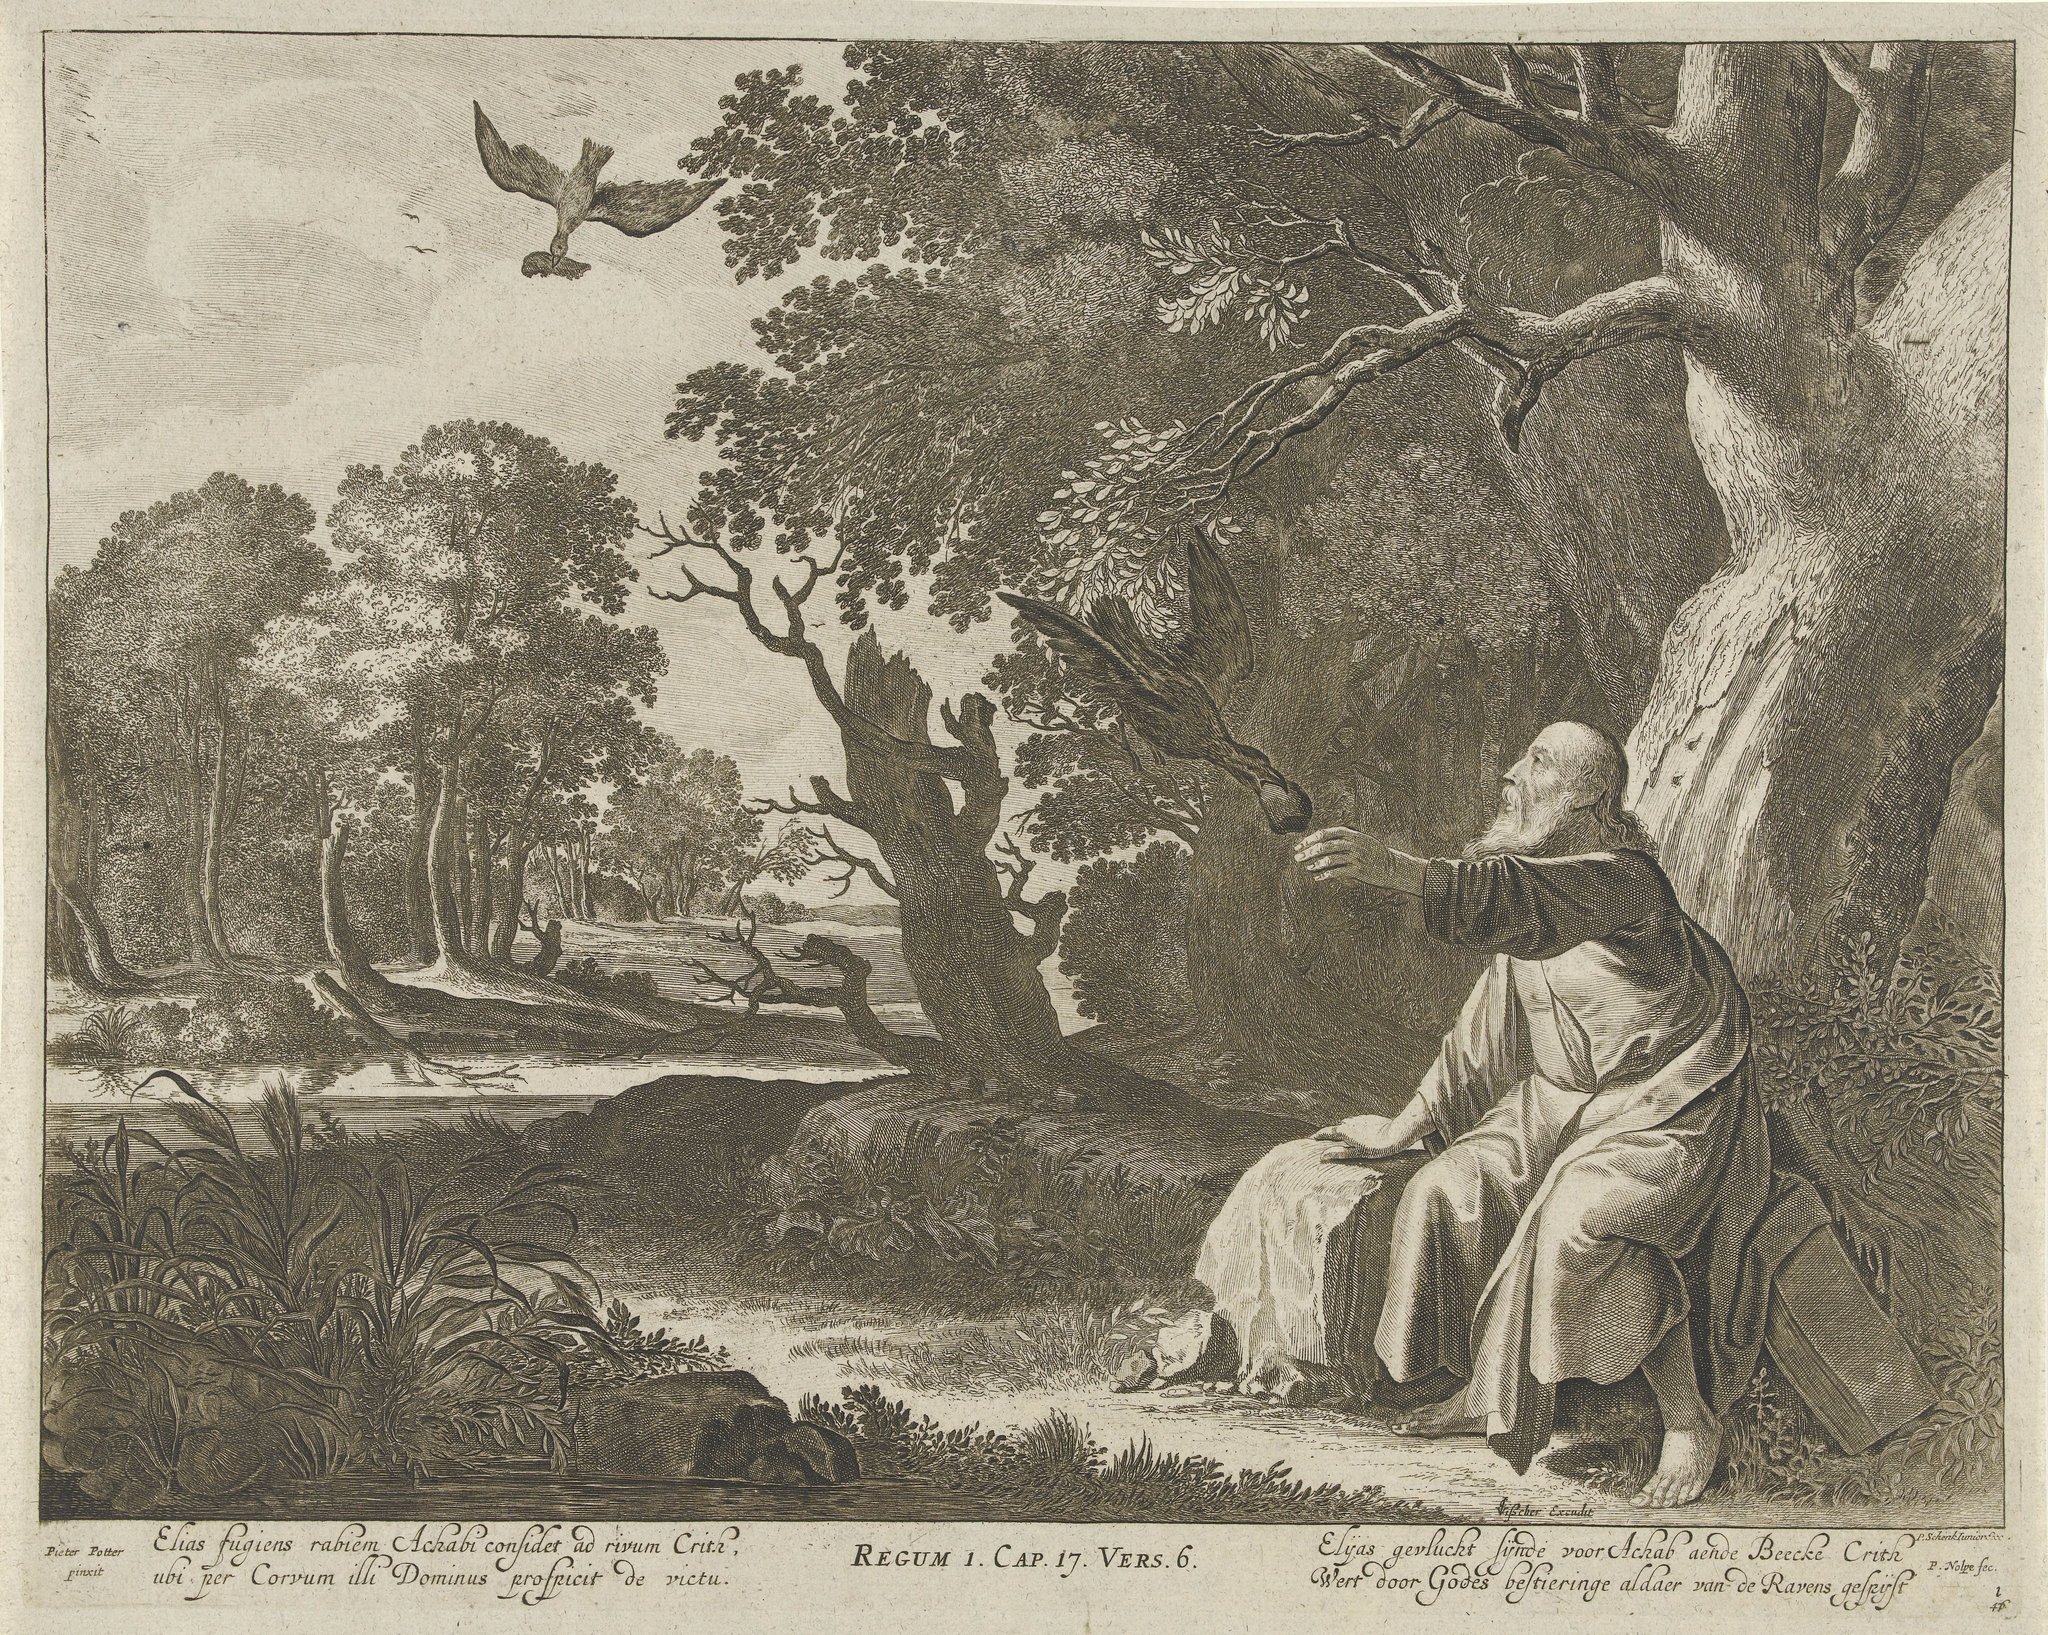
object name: print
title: Elia gevoed door de raven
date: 1728-1761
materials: paper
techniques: engraving, etching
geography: amsterdam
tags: elijah fed by the raven(s): while the prophet is living by the brook, ravens bring him food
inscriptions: collector's mark: Lugt 2228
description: Elia zit onder een boom aan een rivier, waar de raven hem brood en vlees komen brengen. Naast hem ligt een groot boek. Naar de Bijbeltekst in 1 Kon. 17:6. Onderaan in de marge twee tweeregelige teksten in het Nederlands.